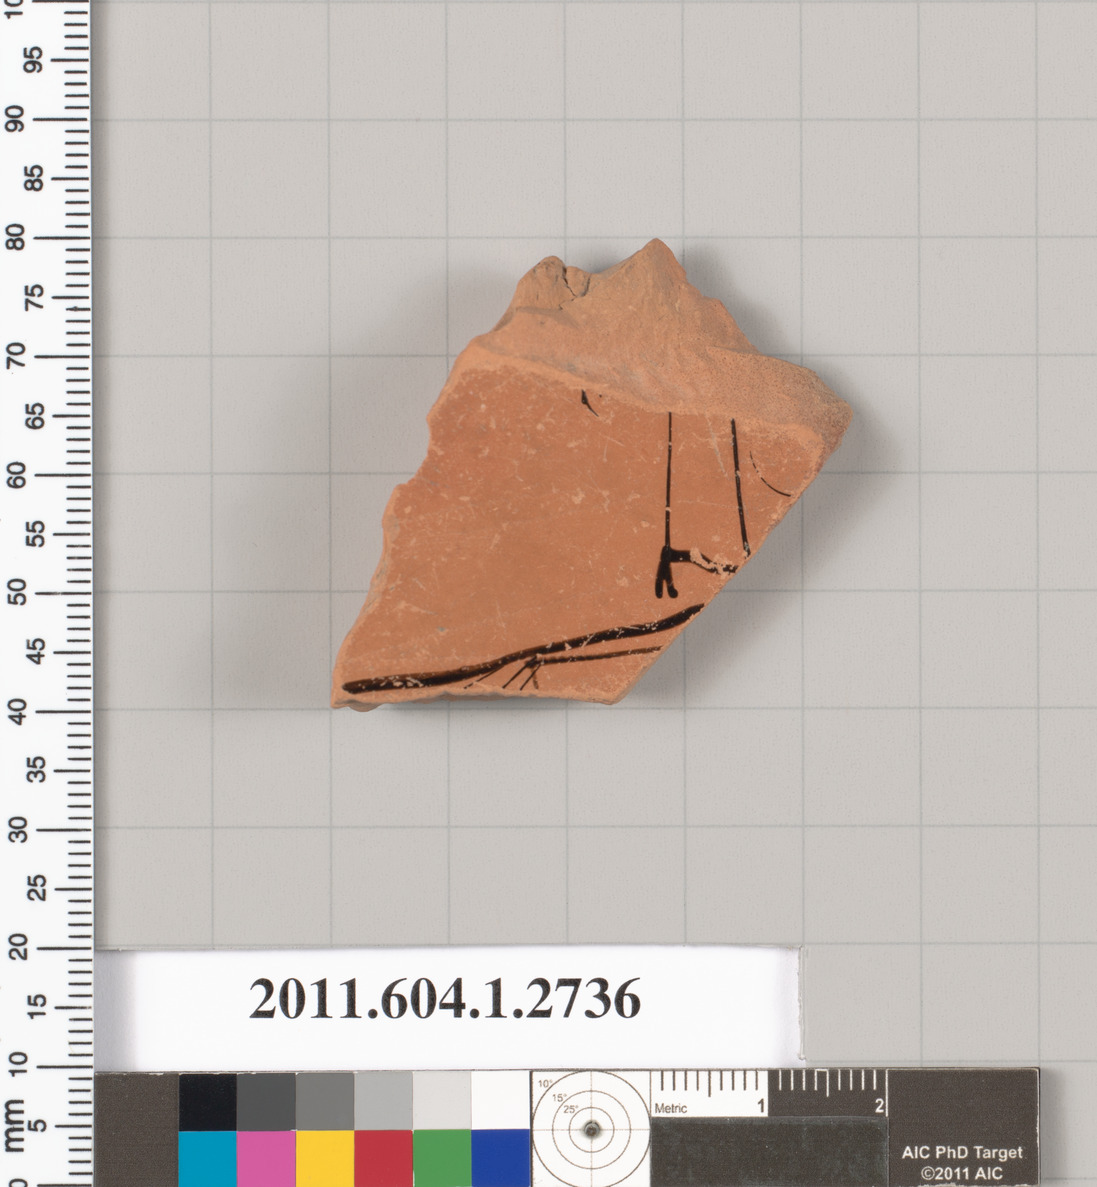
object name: kylix fragment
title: Terracotta fragment of a kylix (drinking cup)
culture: greek, attic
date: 475-451 BCE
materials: terracotta